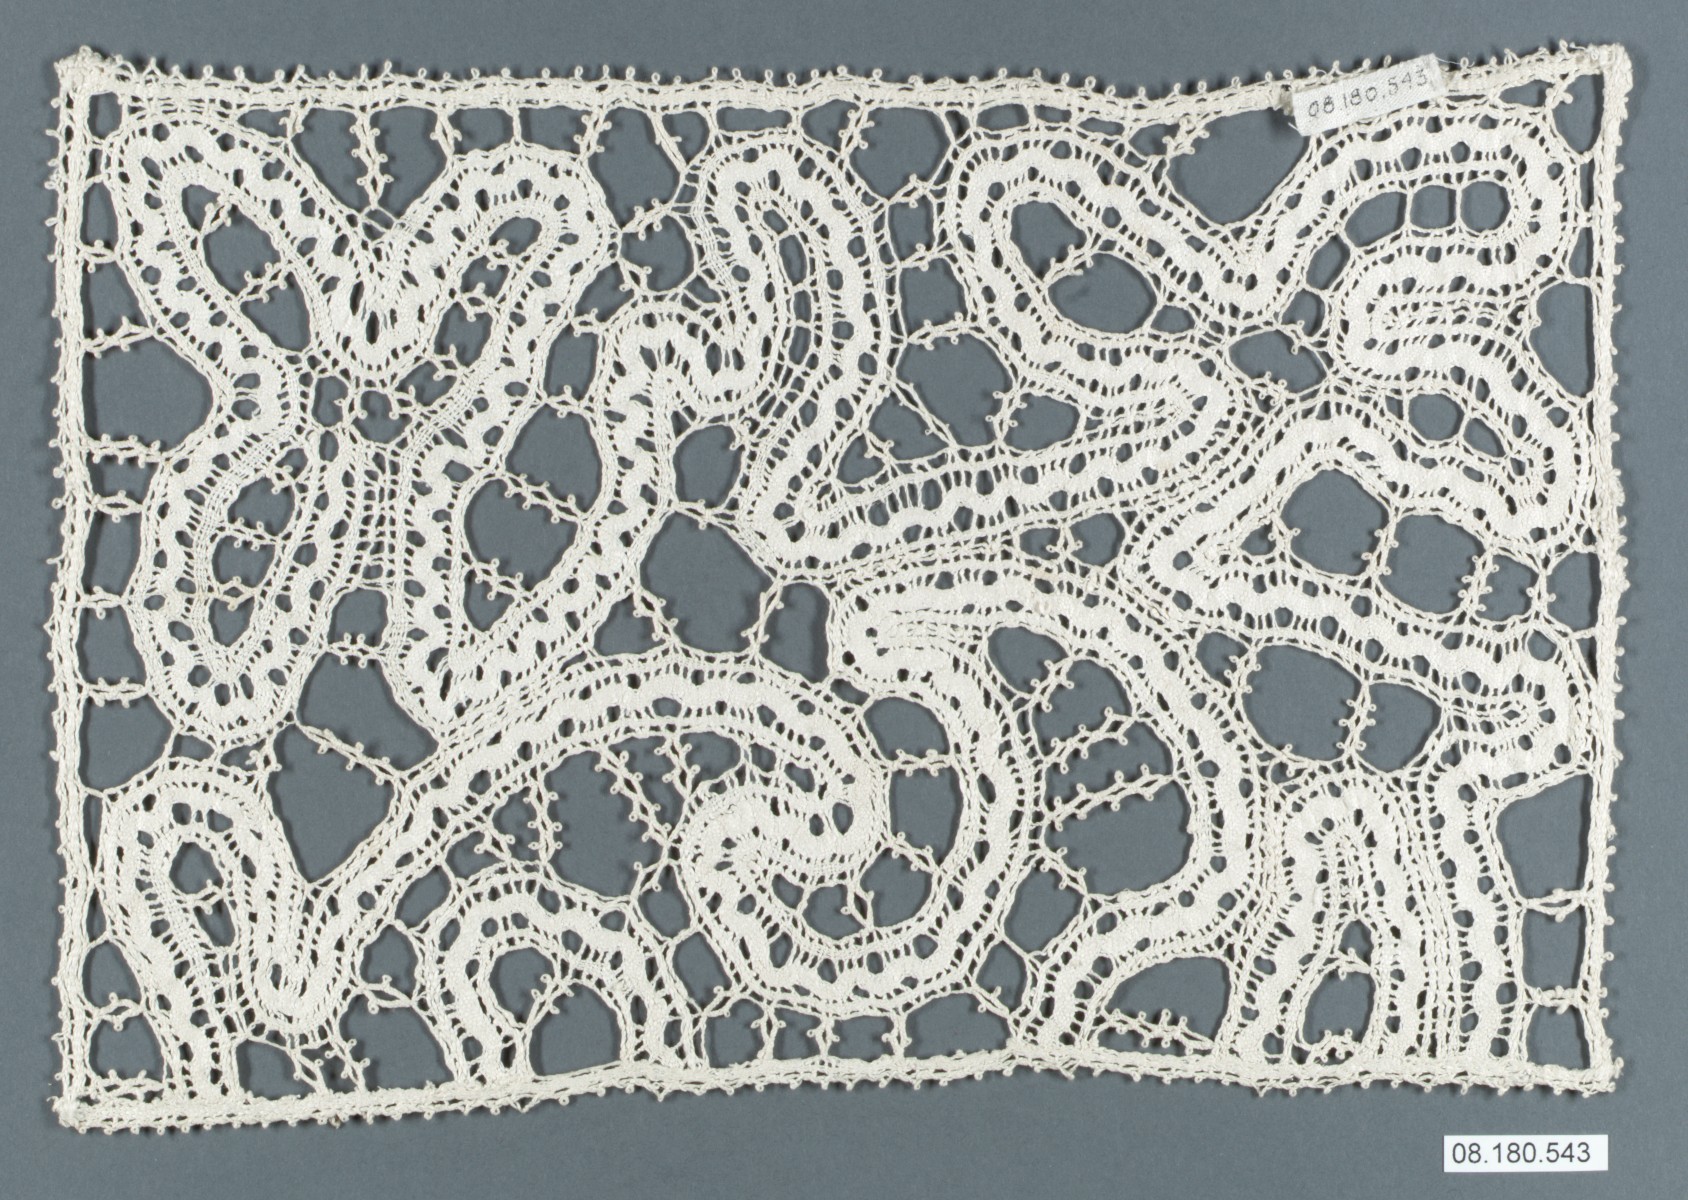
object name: fragment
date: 1601-1700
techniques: lace